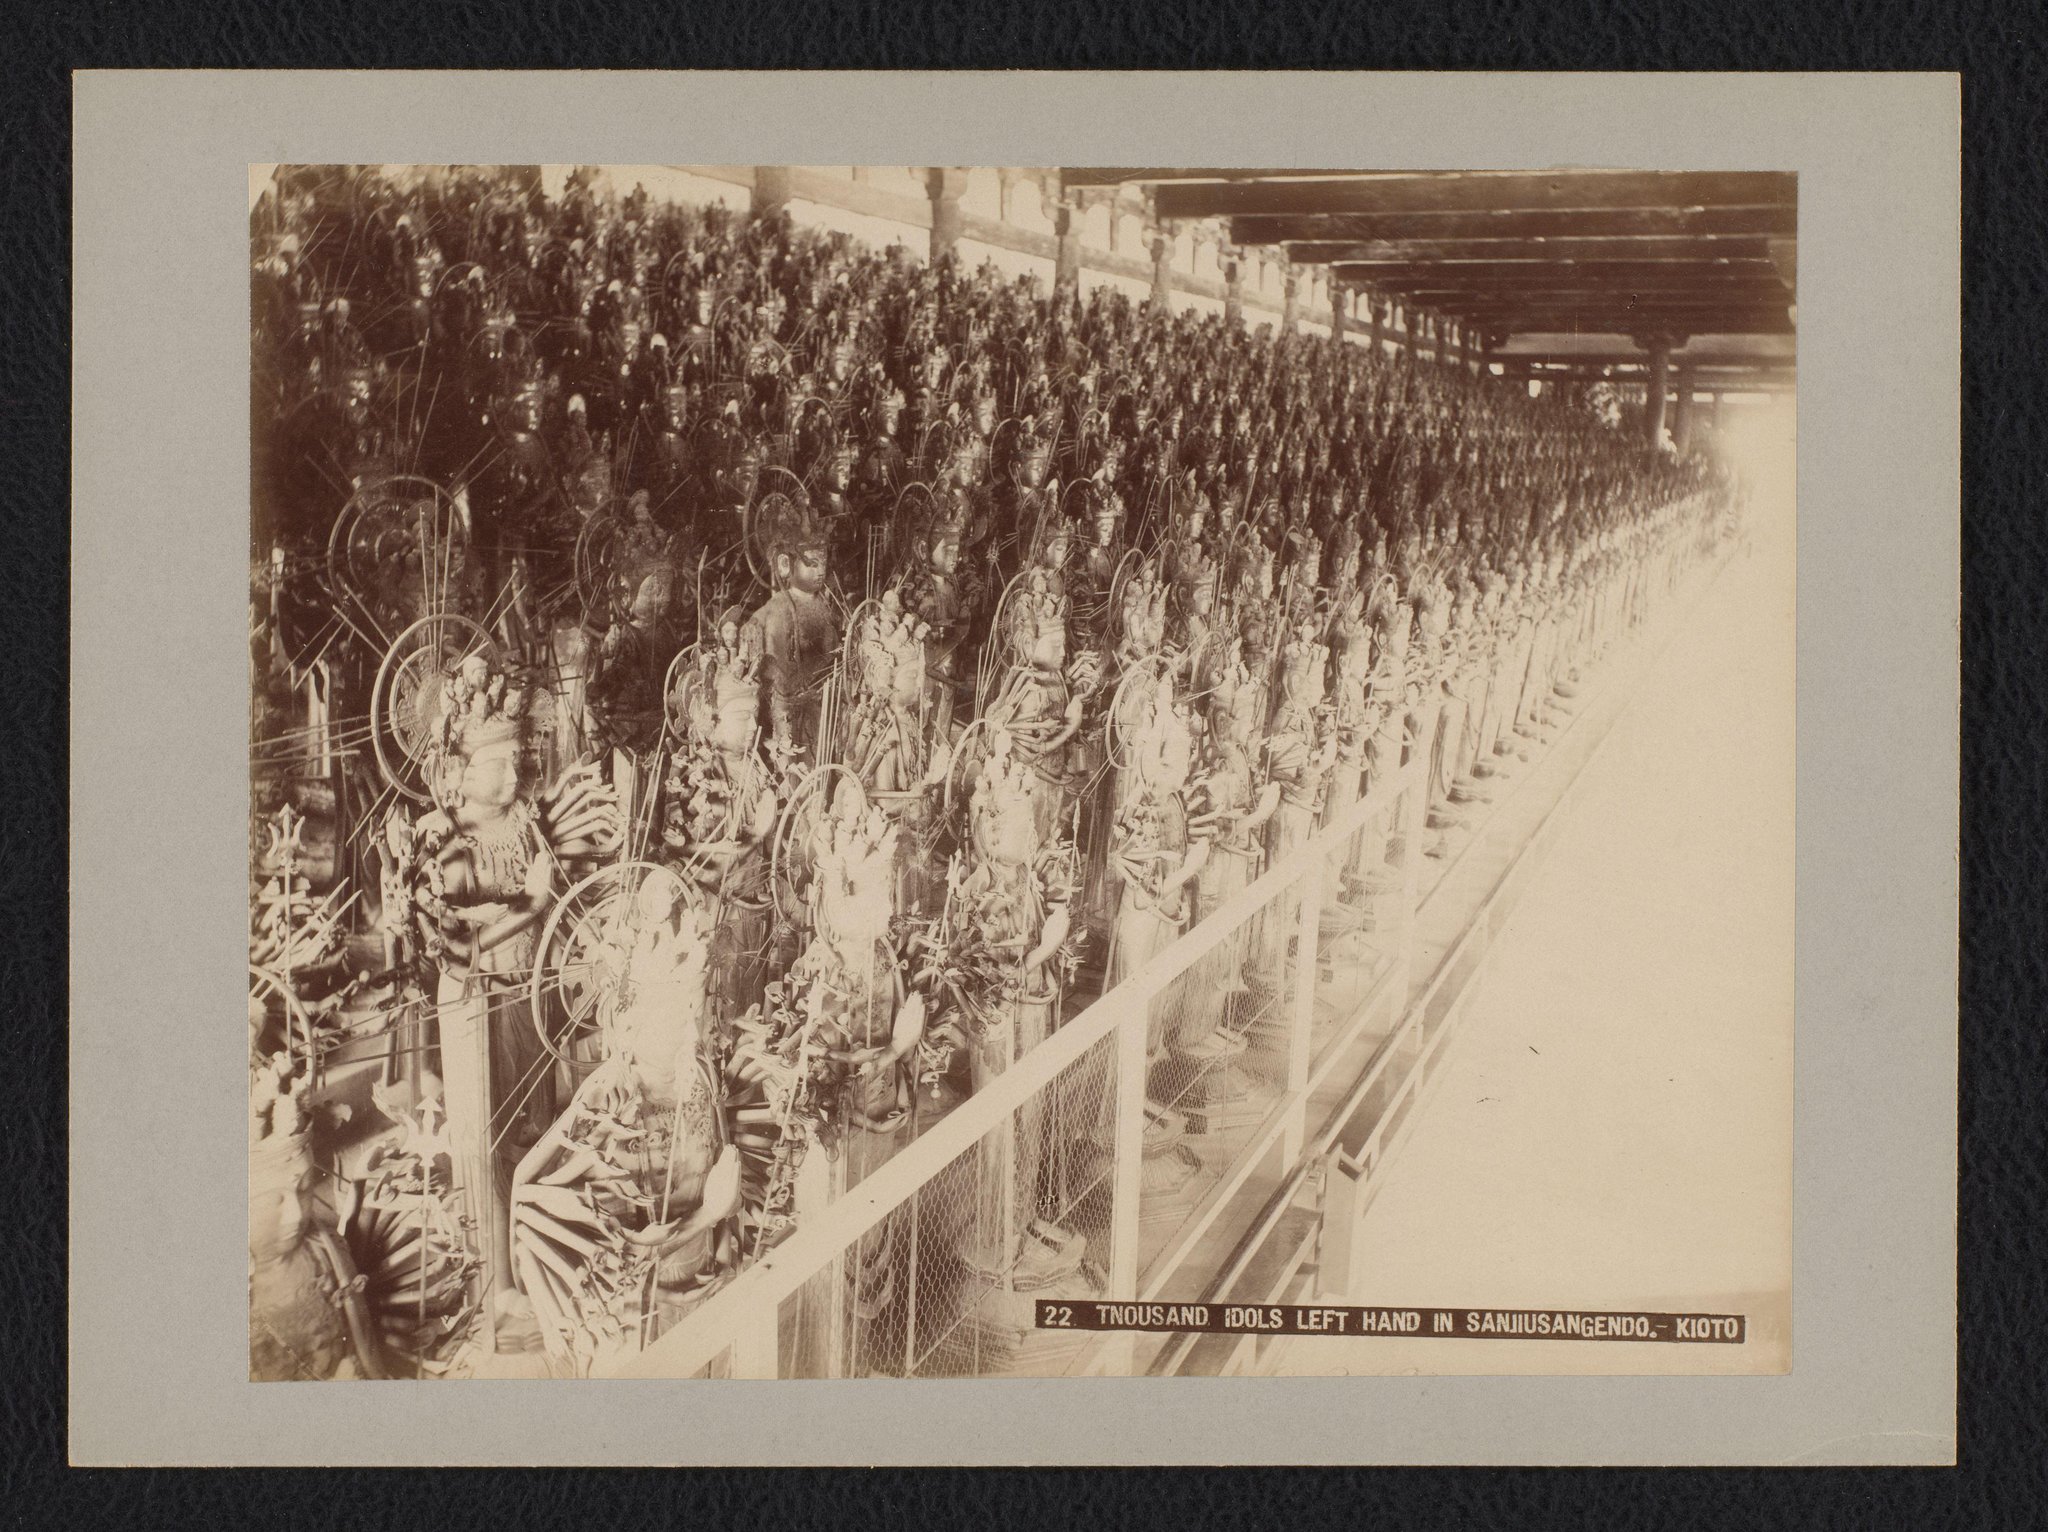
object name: photograph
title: Houten beelden van Kannon in de Tempel Sanjusangendo, Kyoto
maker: Anonymous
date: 1895-1915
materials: cardboard, photographic support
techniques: albumen print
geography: kyoto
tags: kyoto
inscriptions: number: ‘9.’